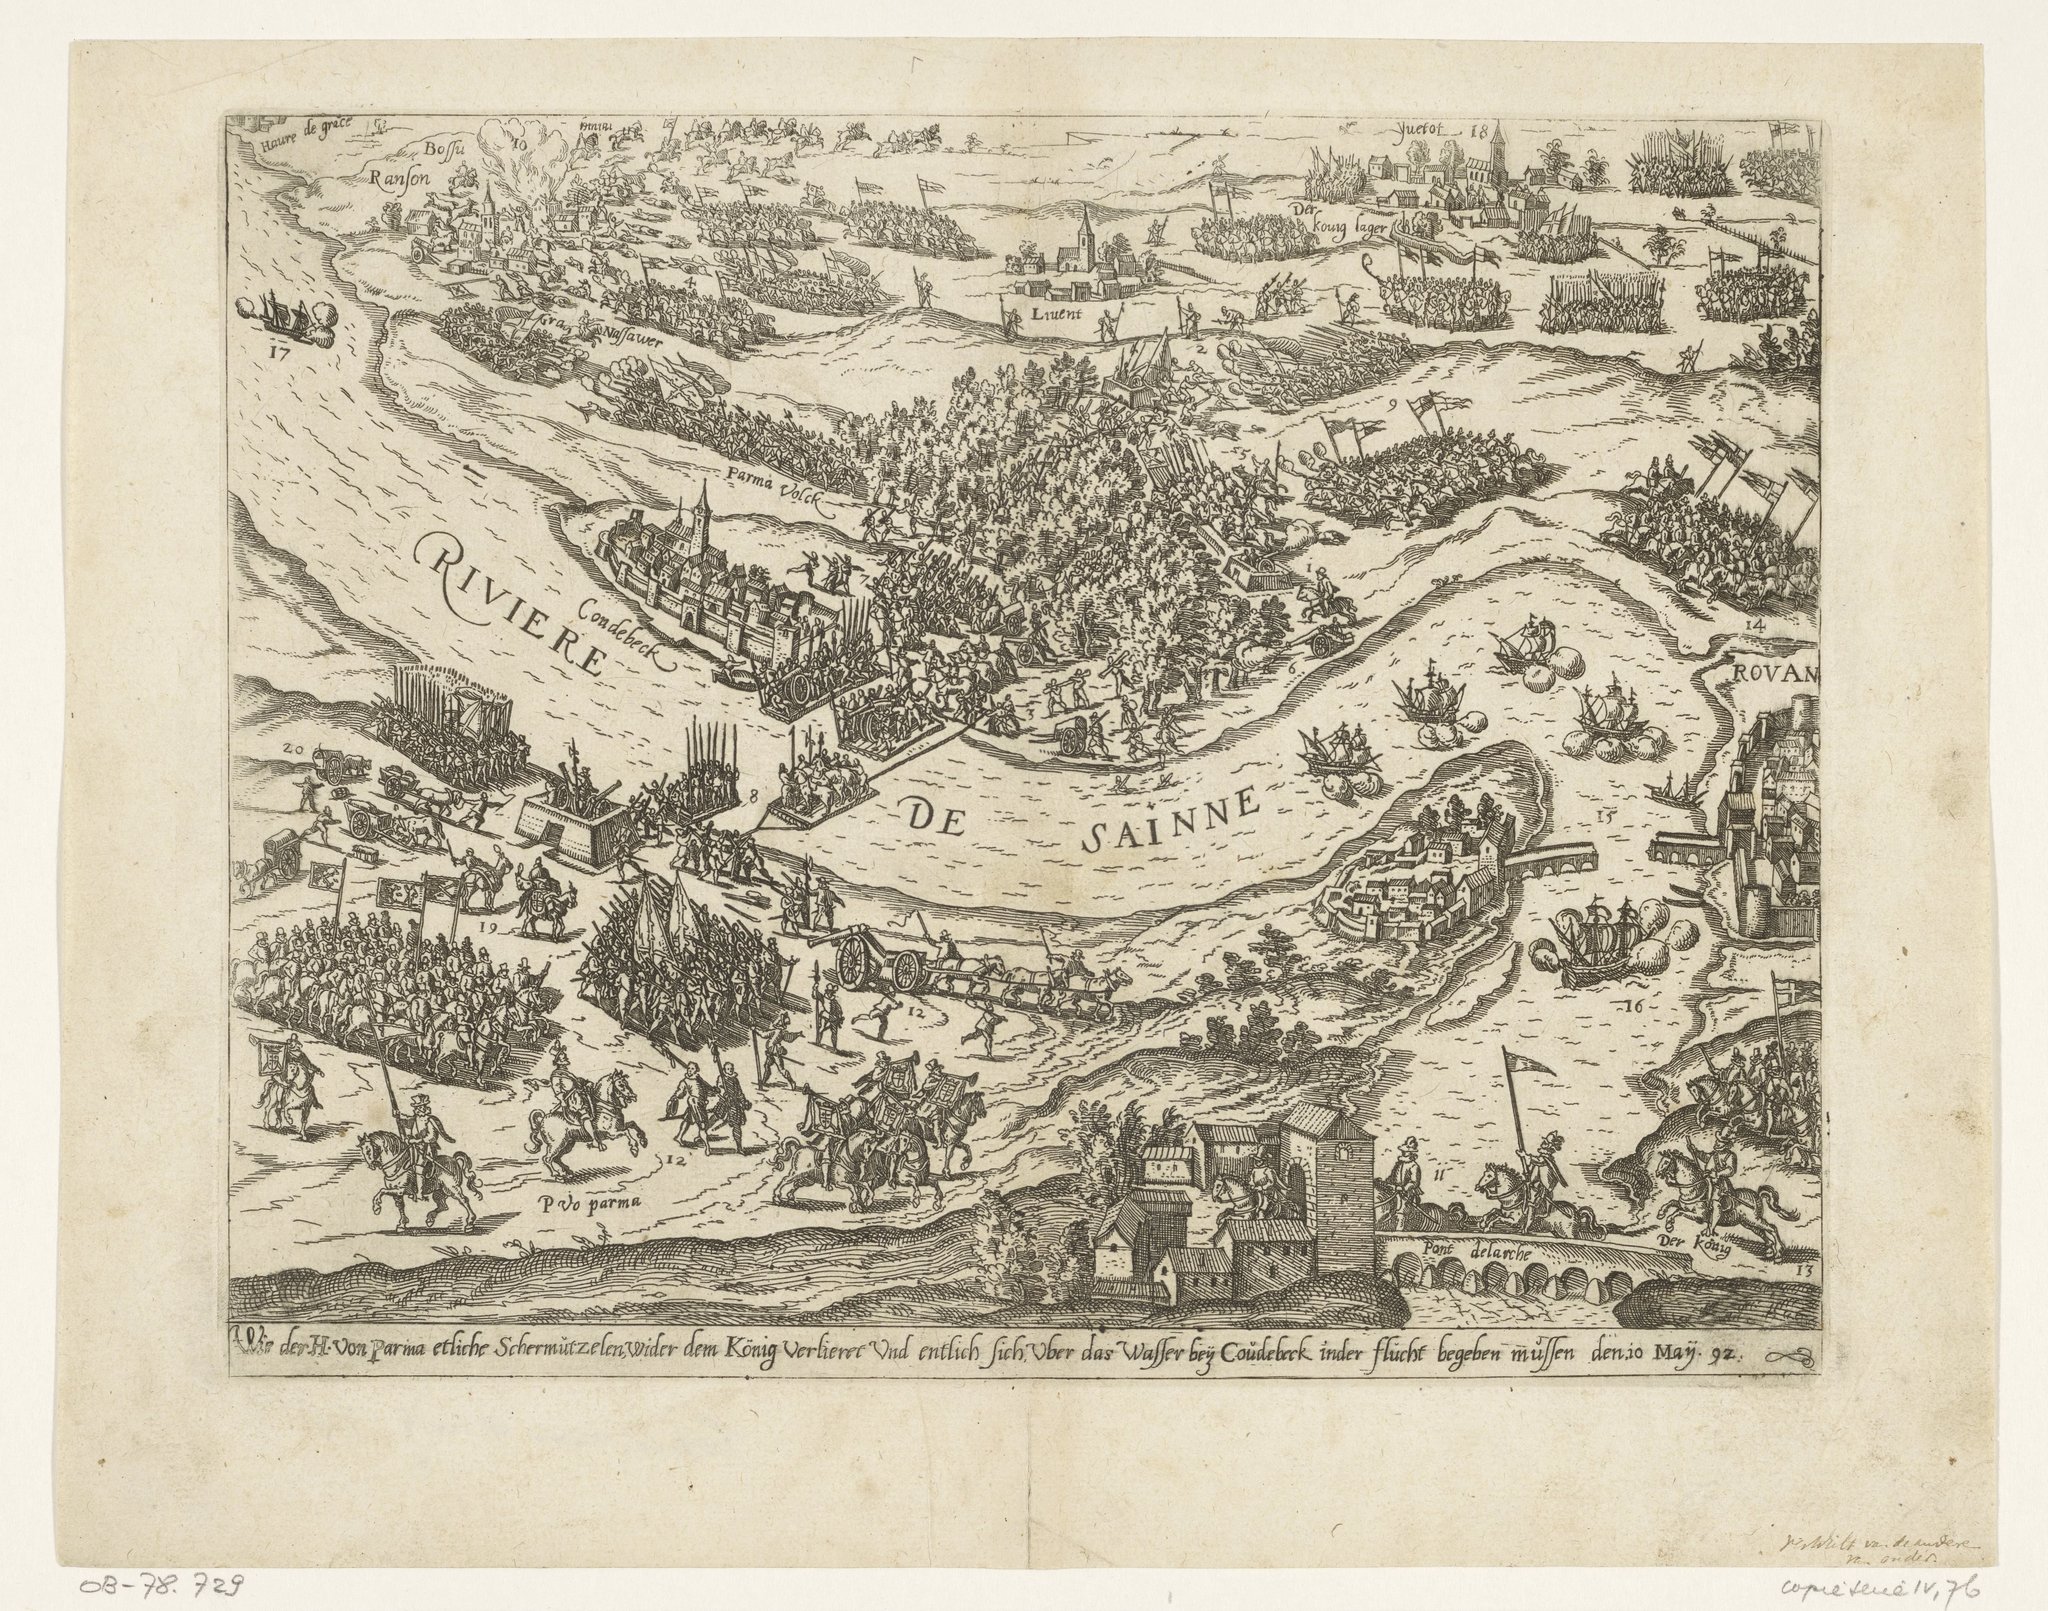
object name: print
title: Parma steekt bij Caudebec de Seine over, 1592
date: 1592-1594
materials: paper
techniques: etching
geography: germany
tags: rome, alessandro farnese (landvoogd van de nederlanden en hertog van parma en piacenza), hendrik iv (koning van frankrijk en navarra), improvised bridge, temporary bridge ~ military engineering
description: Het leger van de hertog van Parma steekt op vlotten bij Caudebec de Seine over, 10 mei 1592. Rechts onder Rouen en koning Hendrik IV. Met onderschrift van 1 regel in het Duits. Ongenummerd. Papier met rode randjes. Kopie naar de prent van Hogenberg.